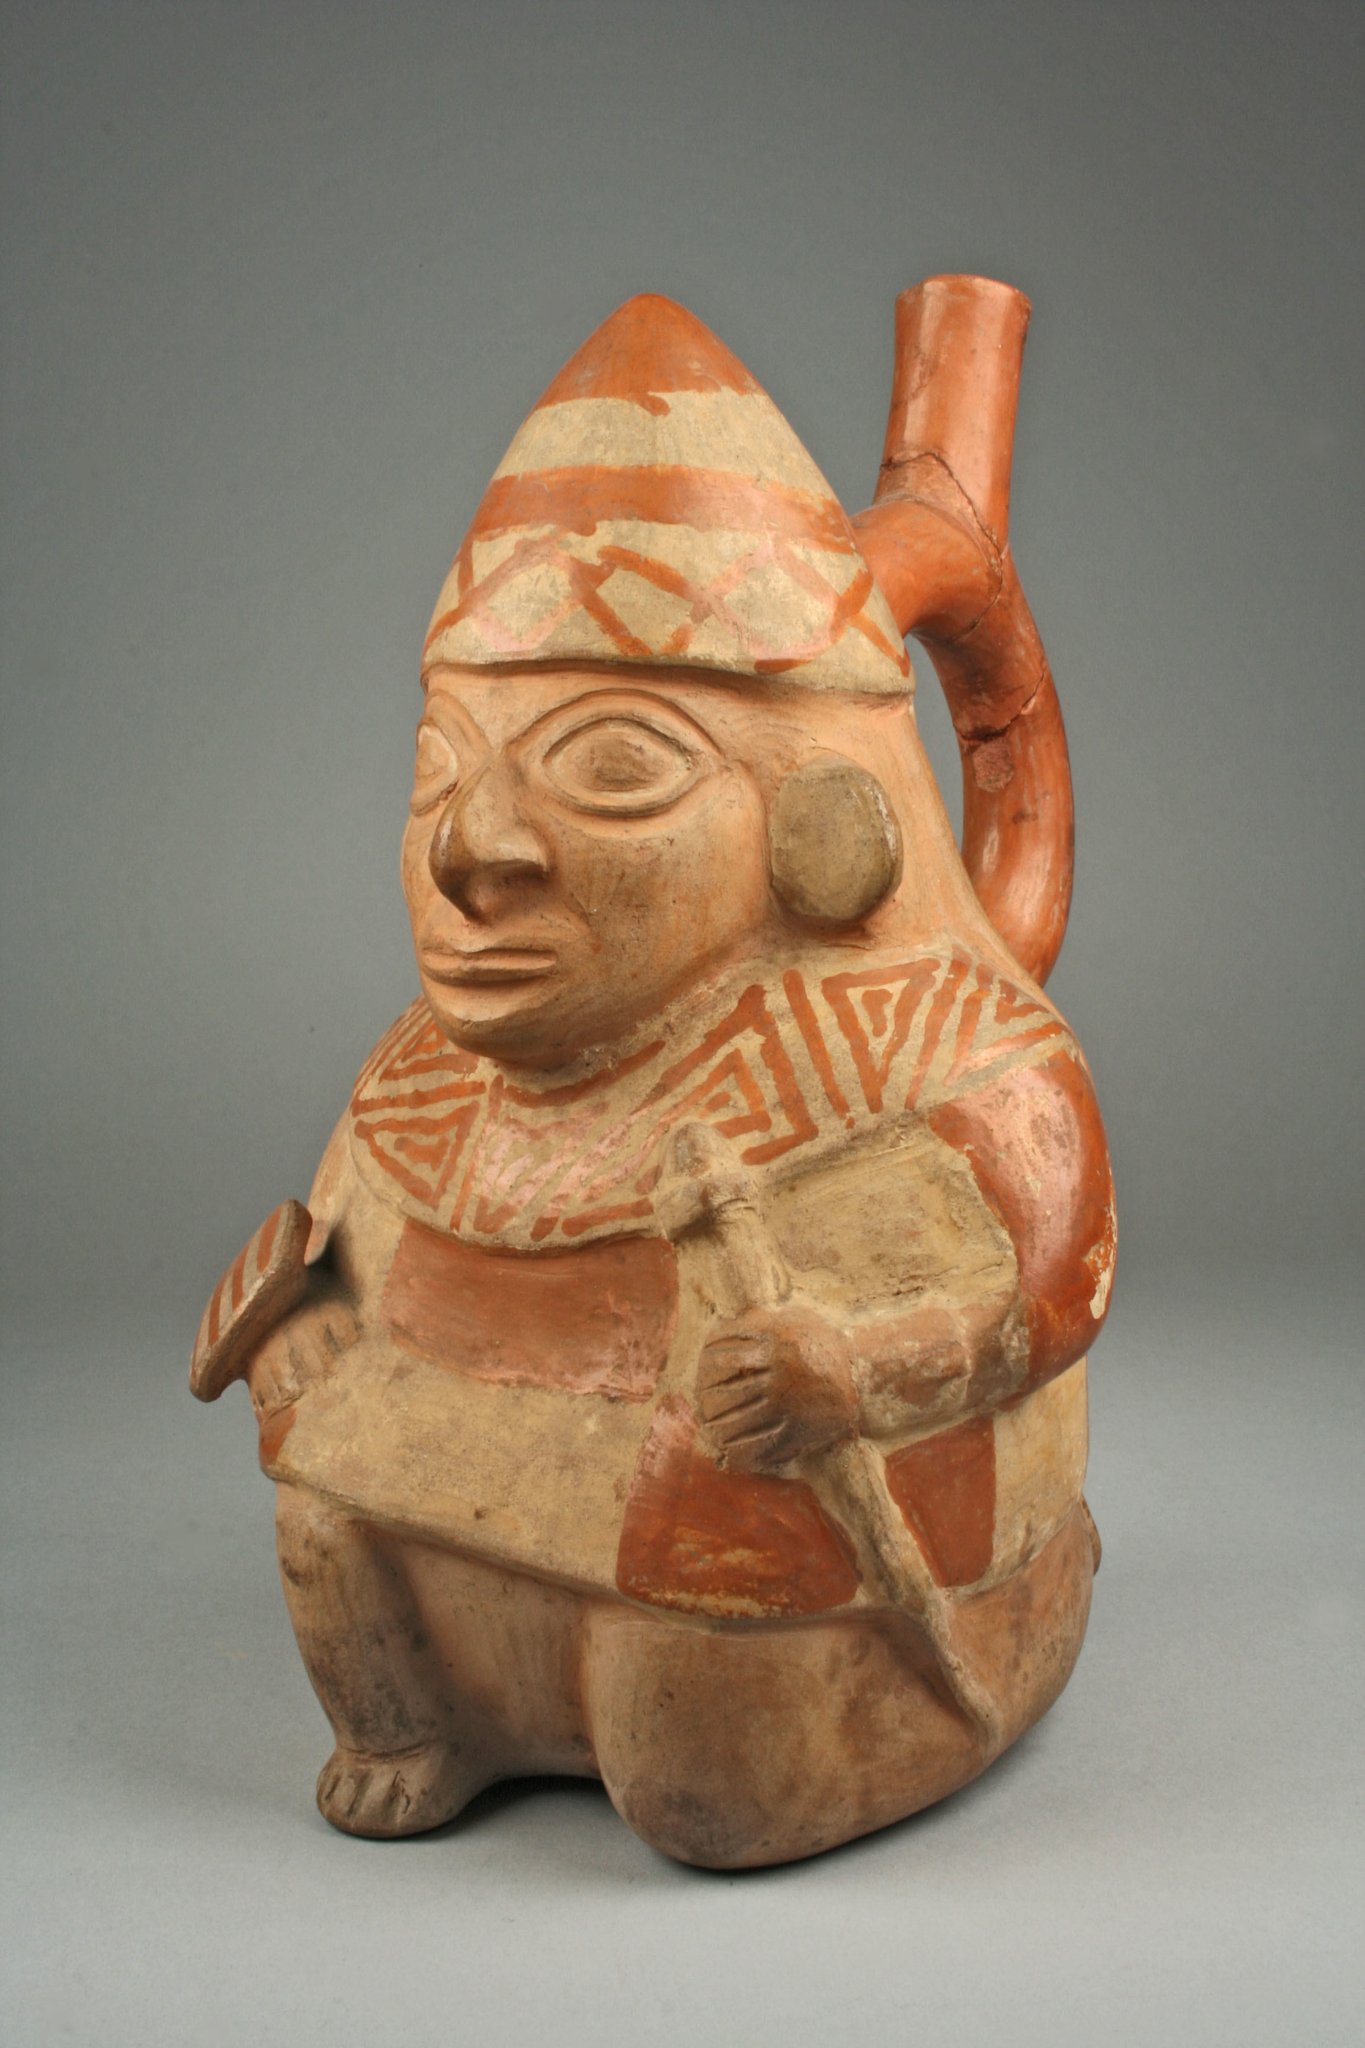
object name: bottle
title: Stirrup Spout Bottle with Kneeling Warrior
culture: moche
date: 1-400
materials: ceramic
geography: peru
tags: warriors